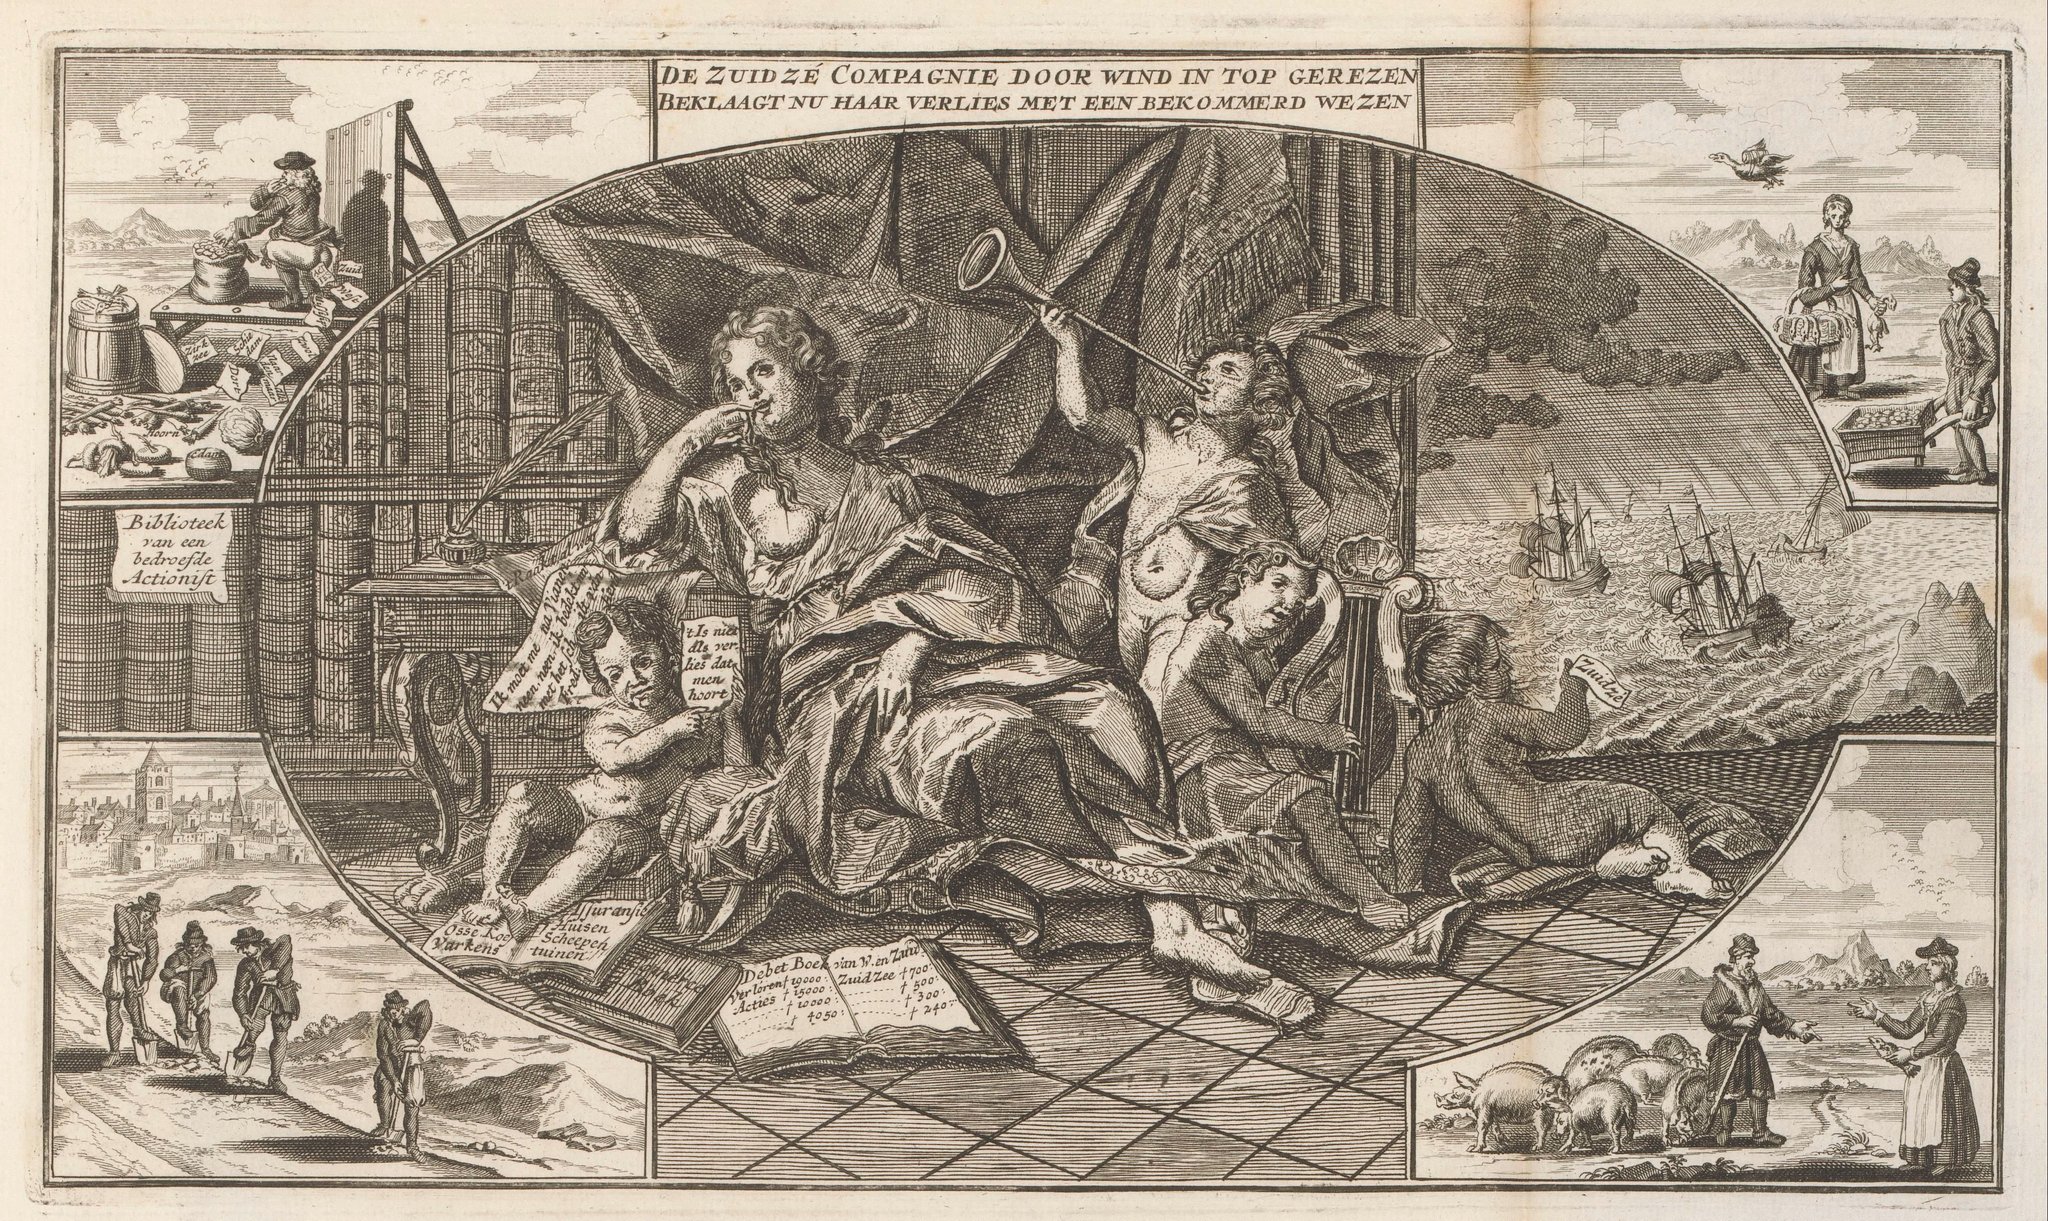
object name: cartoon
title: De Zuidzé Compagnie door wind in top gerezen / Beklaagt nu haar verlies met een bekommerd wezen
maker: Anonymous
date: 1720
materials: paper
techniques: etching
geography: northern netherlands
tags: defecation, merchant shipping, shipping trade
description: Klacht van de Zuidzee-Compagnie, 1720. De vrouwelijke personificatie van de Zuidzee-Compagnie met haar kinderen liggend tussen boeken met schulden op een sofa. Tegen een achtergrond met boeken aangeduid als: Bibliotheek van een bedroefde Actionist. Met kleine scènes van andere mislukte ondernemingen, linksboven worden actien door een man uitgescheten. Onder de voorstelling een onderschrift met een vers in drie kolommen gedrukt van een aparte plaat. Prent in de gebonden eerste uitgave (304 B 10) van Het Groote Tafereel der Dwaasheid met spotprenten op de Windhandel of Actiehandel van 1720.